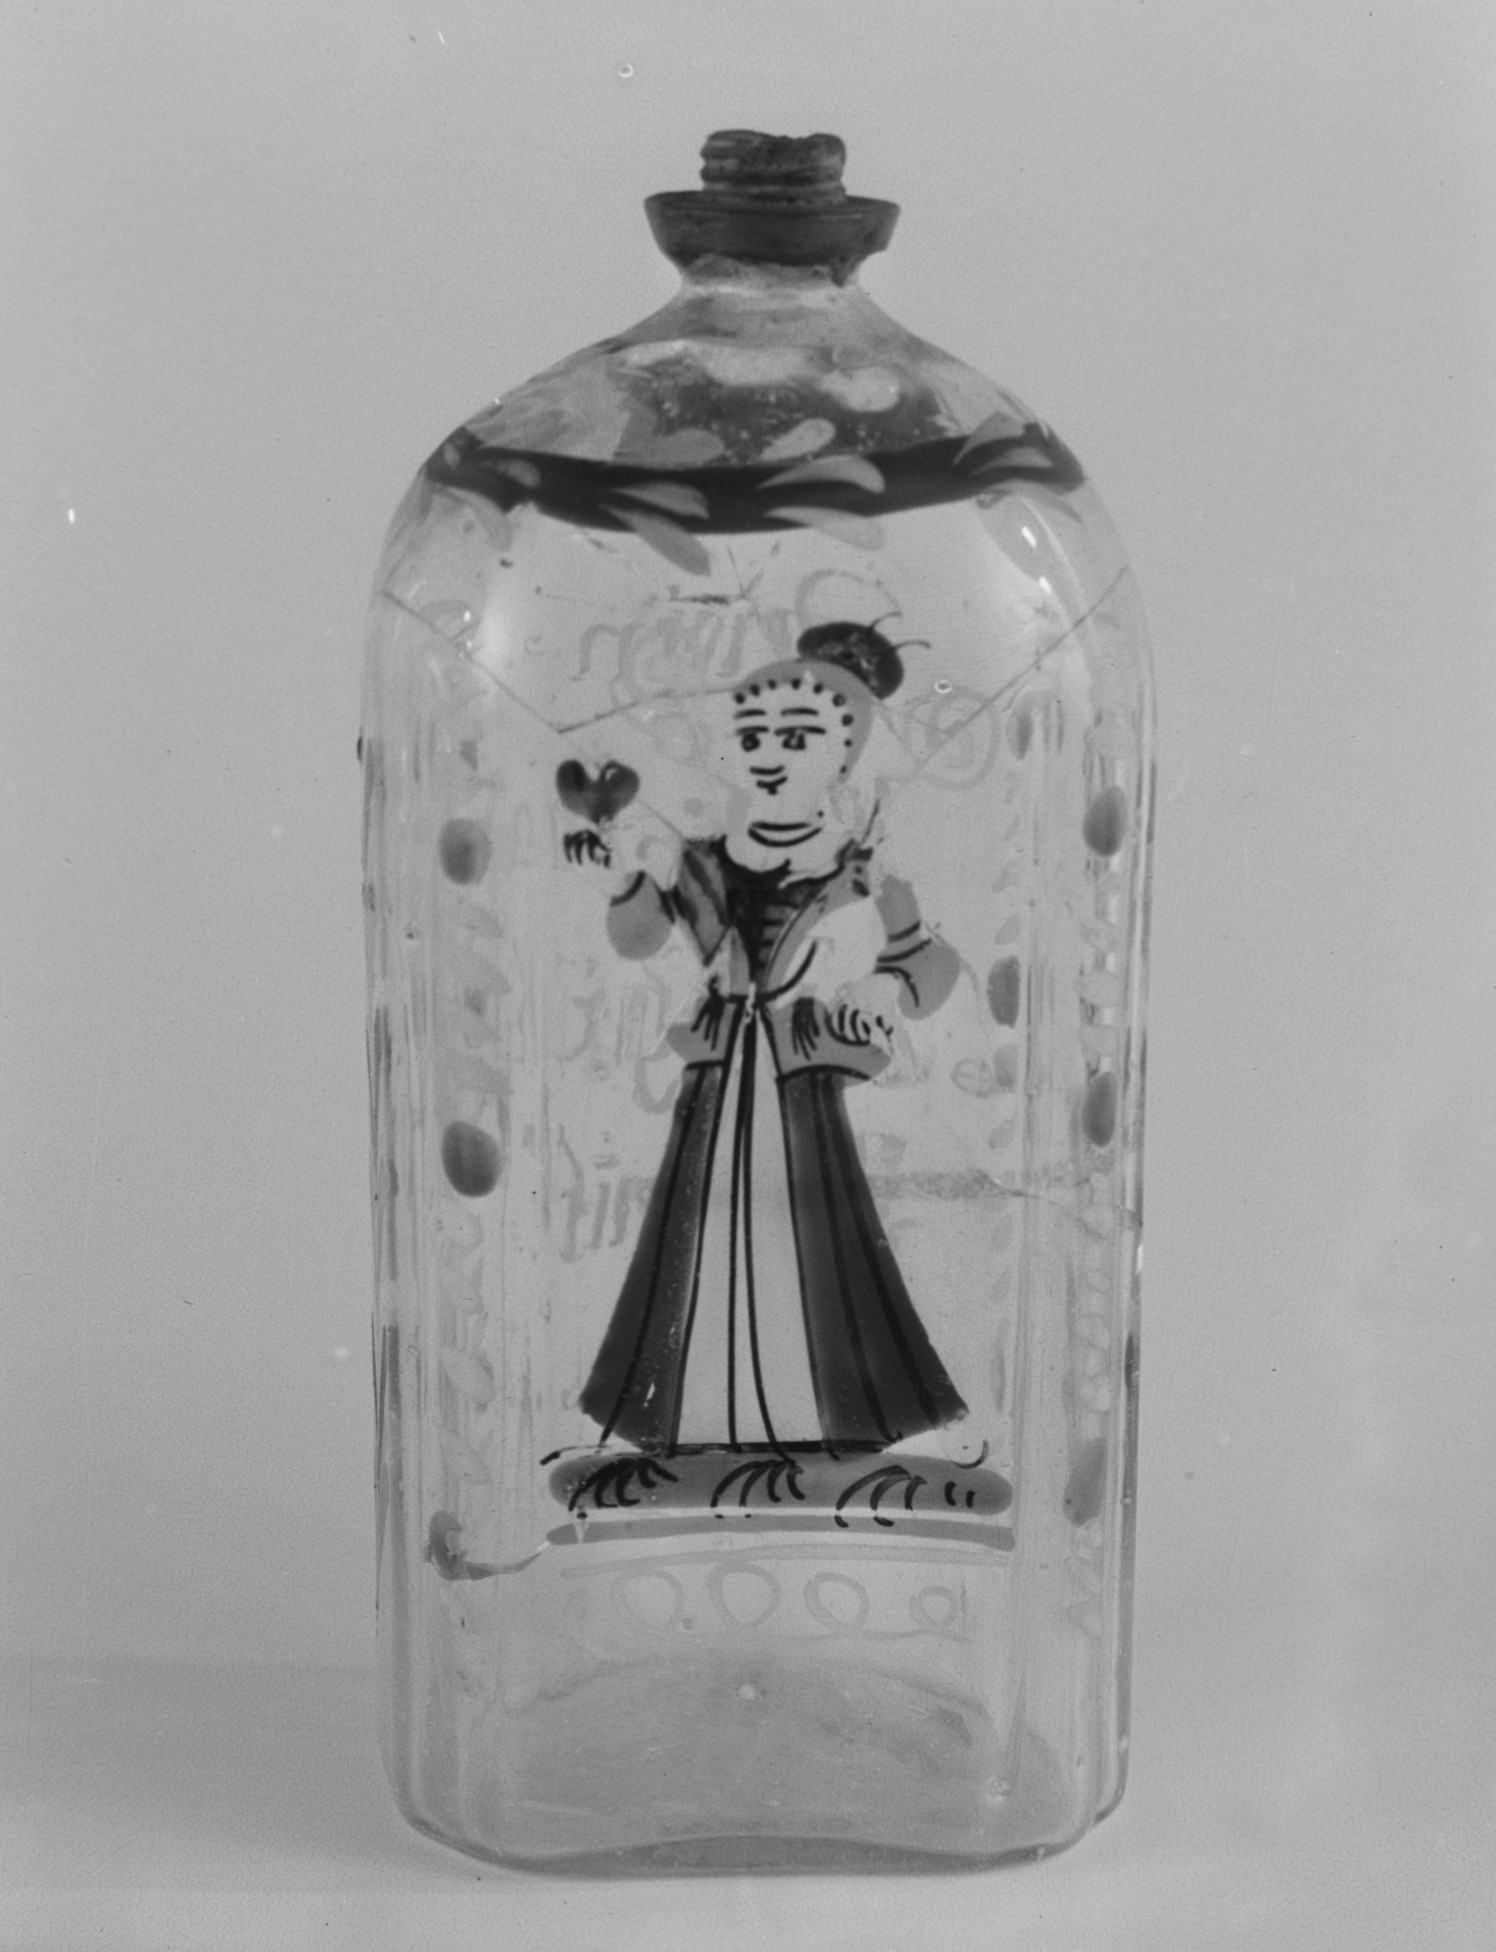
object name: bottle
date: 1701-1800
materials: glass, pewter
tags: women